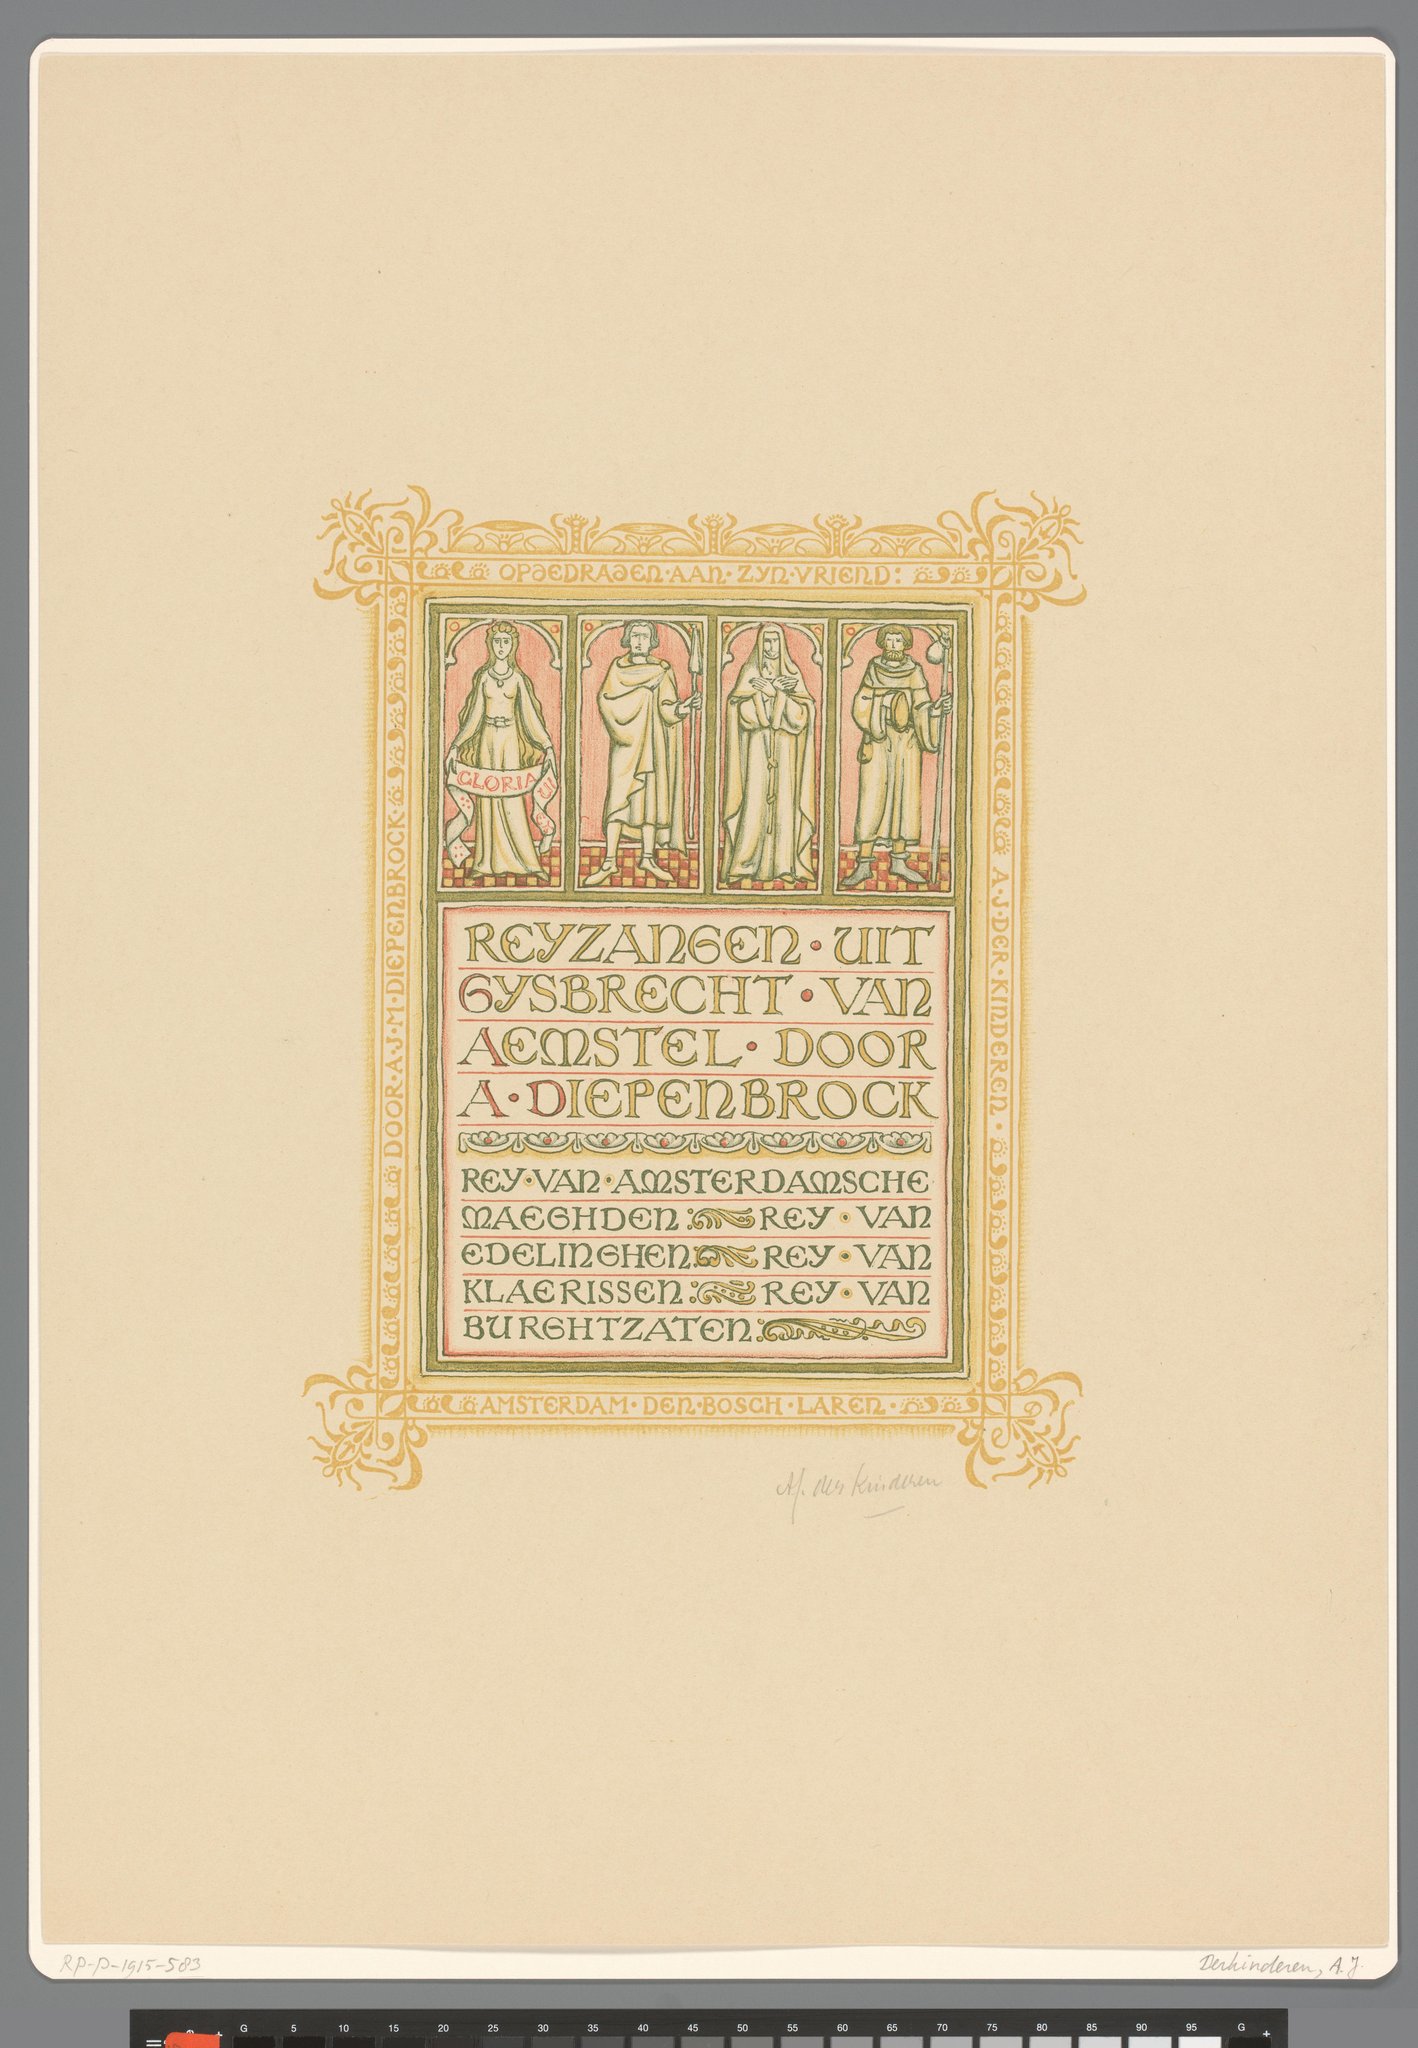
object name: print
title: Reyzangen uit Gysbreght van Aemstel door A. Diepenbrock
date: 1894-1901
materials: paper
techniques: lithograph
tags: amsterdam, painter, print maker, draughtsman, antoon derkinderen, alphons diepenbrock, standing figure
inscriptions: collector's mark: Lugt 2233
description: De beeltenis van een maagd, een edelman, een zuster en een burchtbewoner boven de tekst 'Rey van Amsterdamsche maeghden, Rey van edelinghen, Rey van Klaerissen, Rey van Burghtzaten'. Om het geheel een sierrand met plantmotieven en de tekst 'Door A.J.M. Diepenbrock opgedragen aan zyn vriend A.J. Derkinderen'.